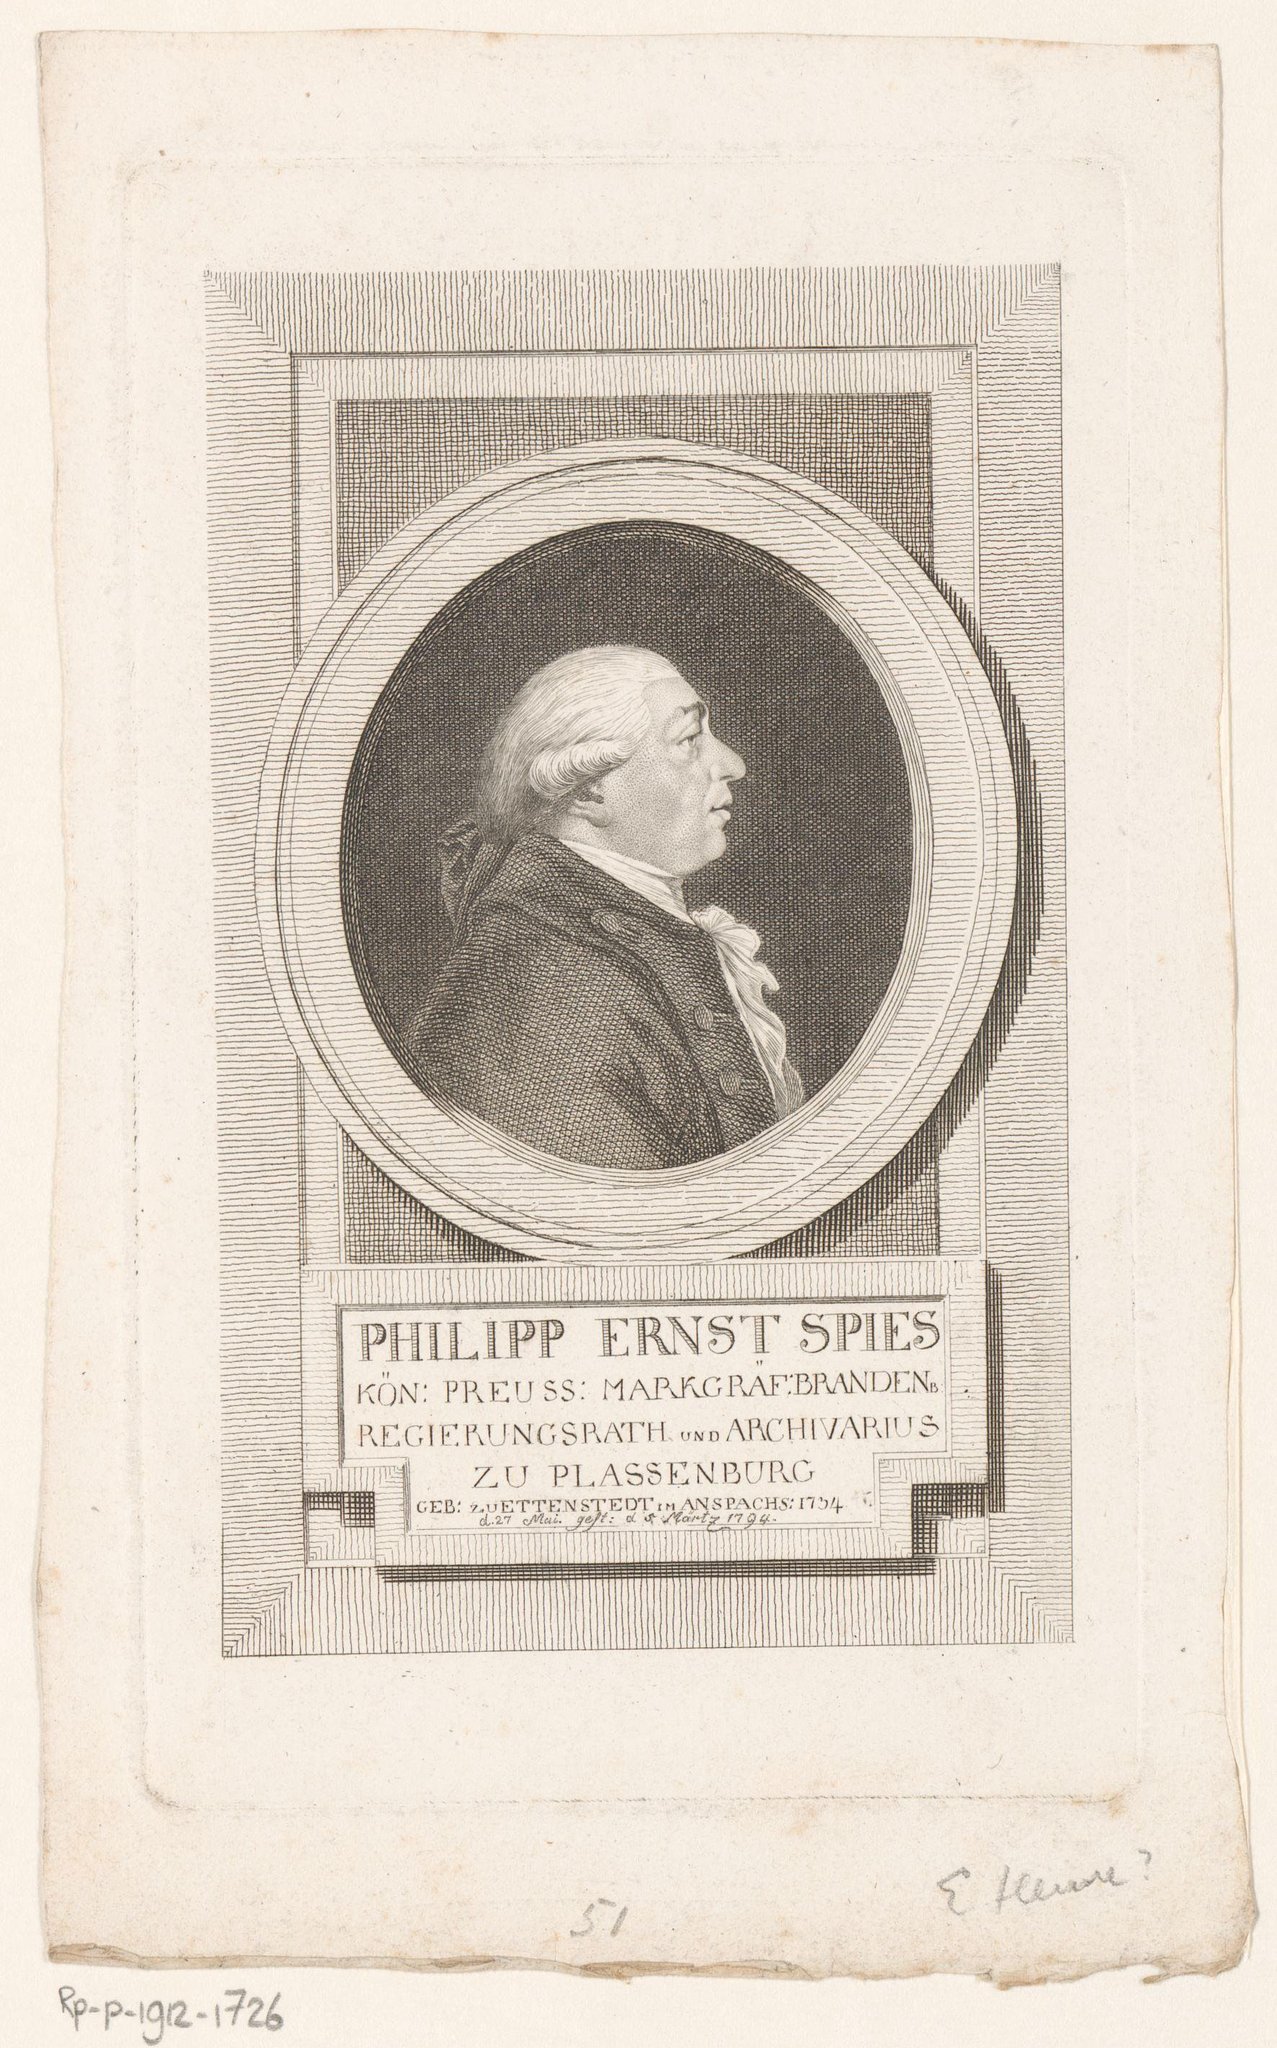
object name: print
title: Portret van Philipp Ernst Spiess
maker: eberhard siegfried henne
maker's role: print maker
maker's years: 1759-1828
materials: paper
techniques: engraving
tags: historical persons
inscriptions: collector's mark: Lugt 2228